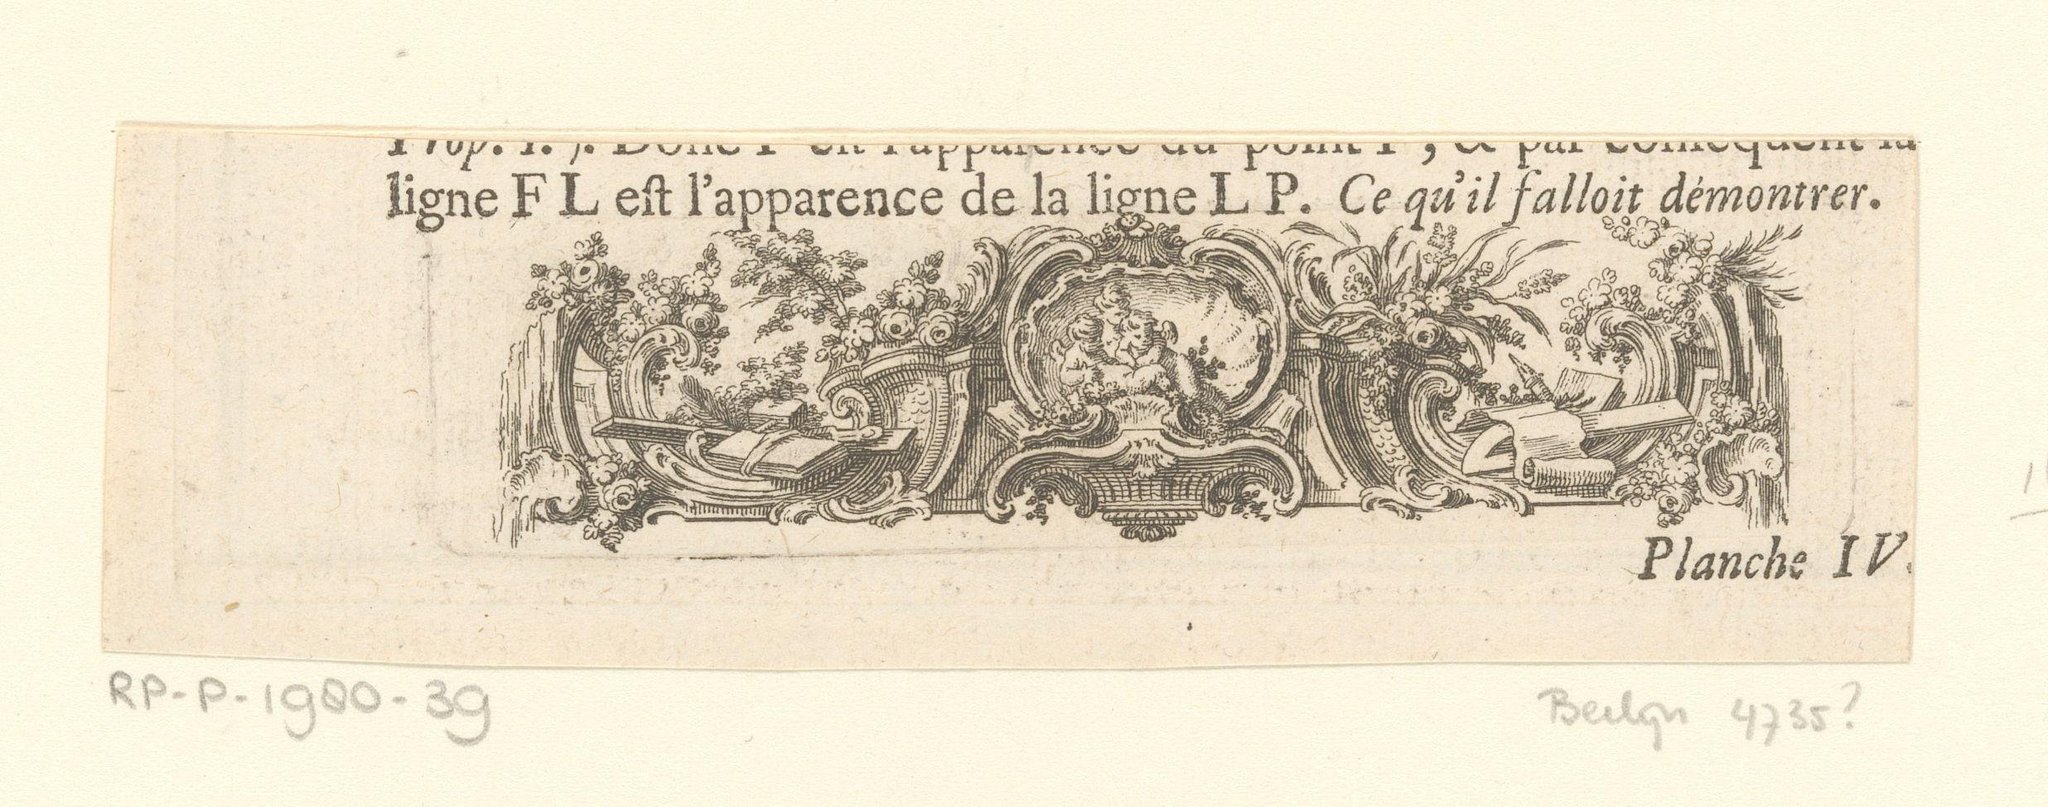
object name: ornament print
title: Vignet met putti in een cartouche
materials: paper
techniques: etching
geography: paris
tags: measuring-instruments, ornament ~ cartouche, cupids: 'amores', 'amoretti', 'putti'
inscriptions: collector's mark: Lugt 2228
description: Pagina 16 uit: Edme-Sébastien. Traité de perspective à l'usage des artistes (...). Parijs: Jombert, Charles Antoine, 1750.